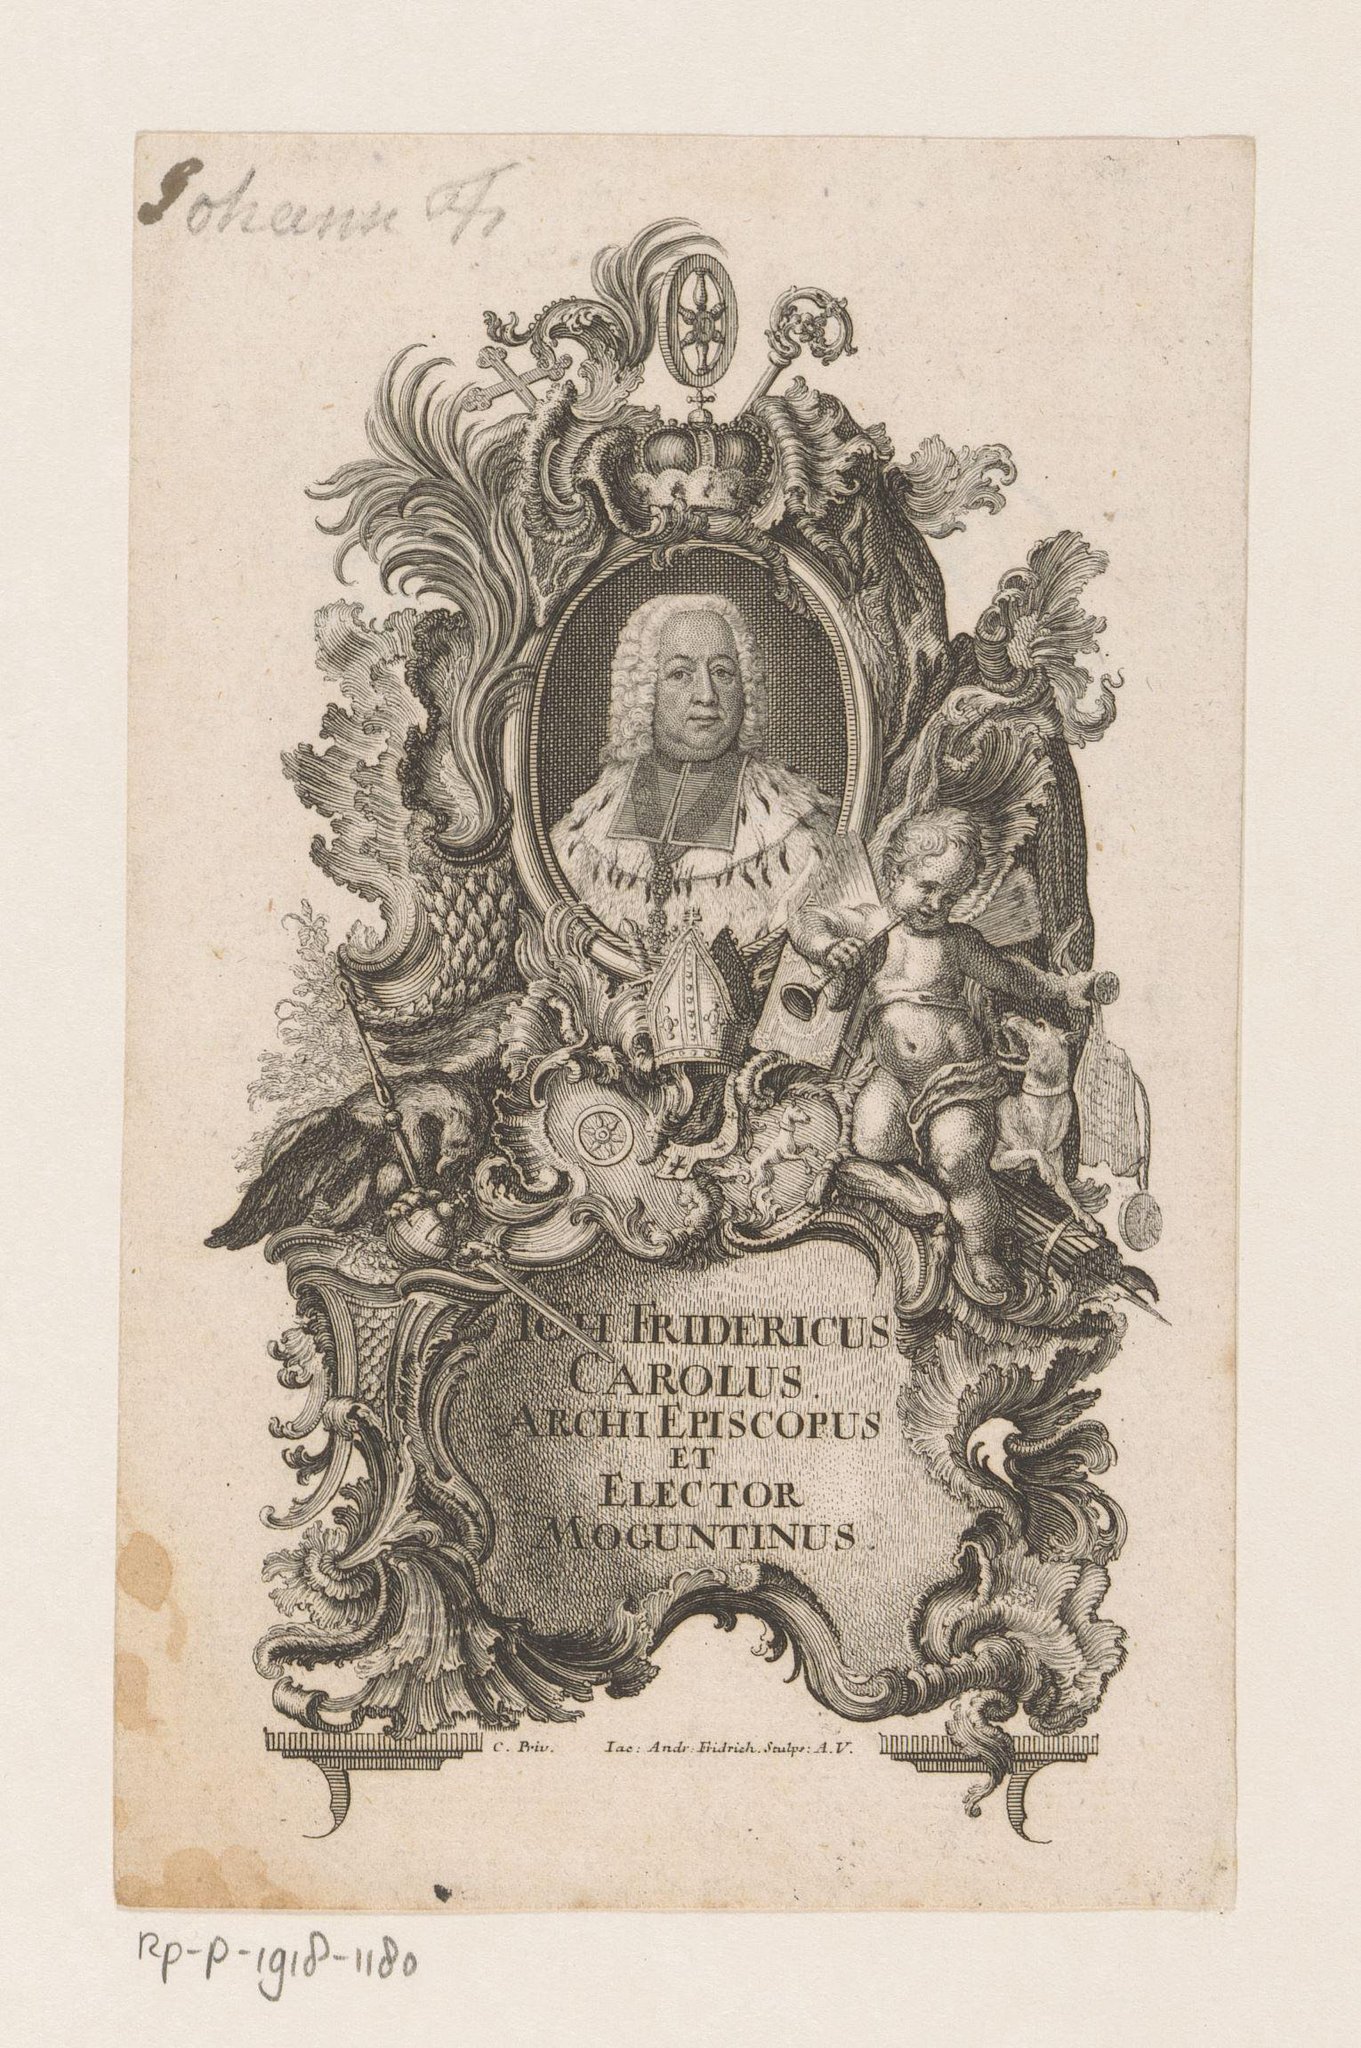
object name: print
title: Portret van Johann Friedrich Carl von Ostein in allegorische omlijsting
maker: jacob andreas fridrich (ii)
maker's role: print maker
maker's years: 1714-1779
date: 1724-1763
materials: paper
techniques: engraving, etching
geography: augsburg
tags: rocaille ornament, insignia of bishop, e.g. mitre, crozier, ornament ~ medallion, historical persons, armorial bearing, heraldry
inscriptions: collector's mark: Lugt 2233